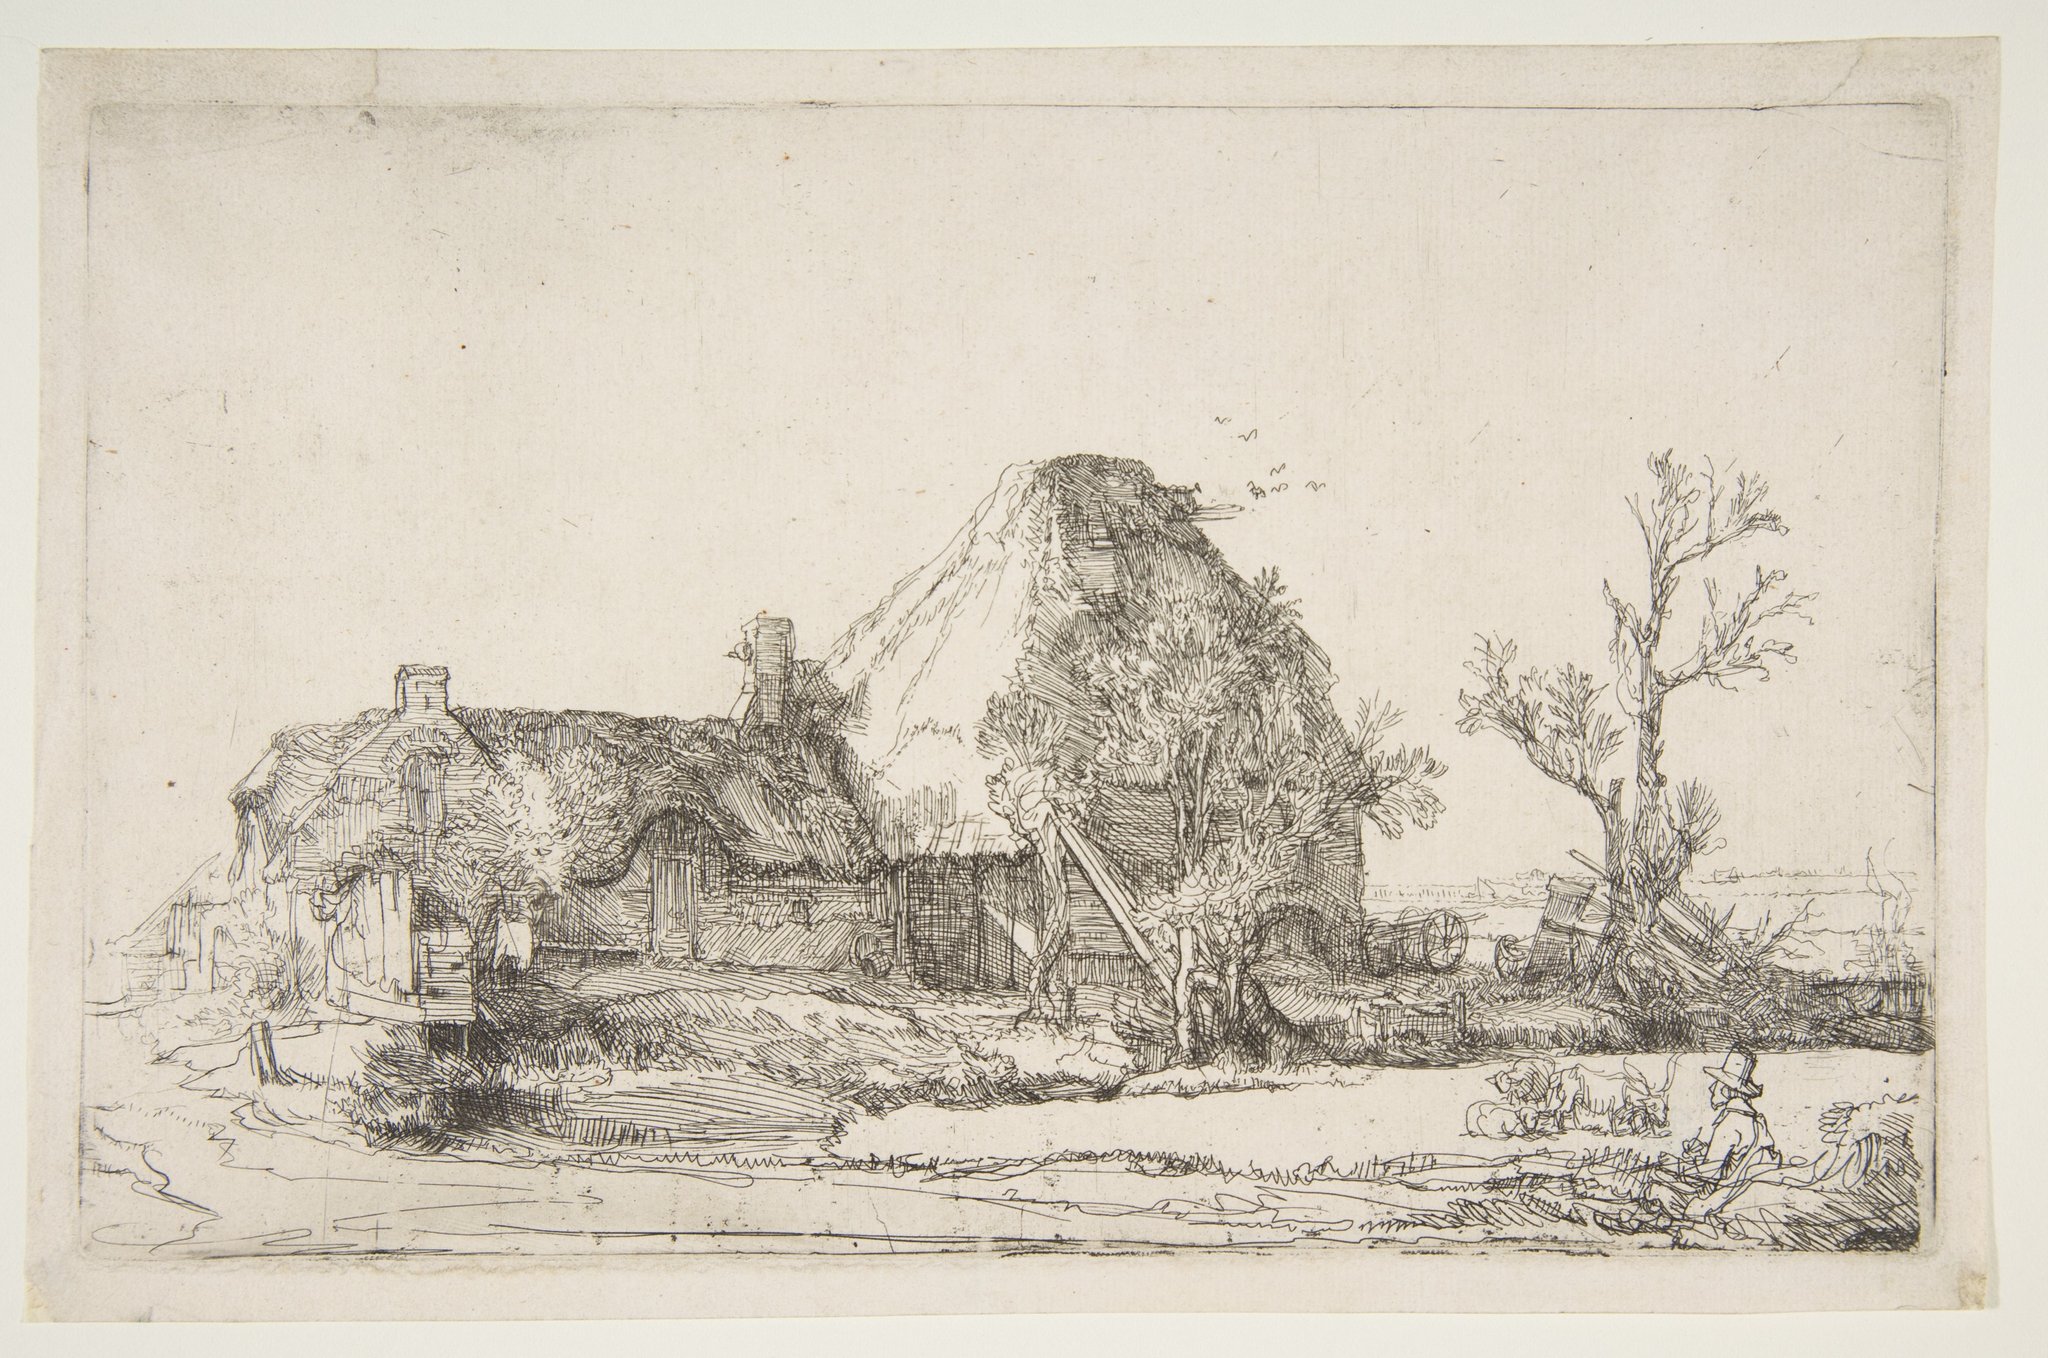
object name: print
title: Cottages and Farm Buildings with a Man Sketching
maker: rembrandt van rijn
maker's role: artist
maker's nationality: dutch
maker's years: 1606-1669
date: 1645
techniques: etching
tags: houses,men,trees